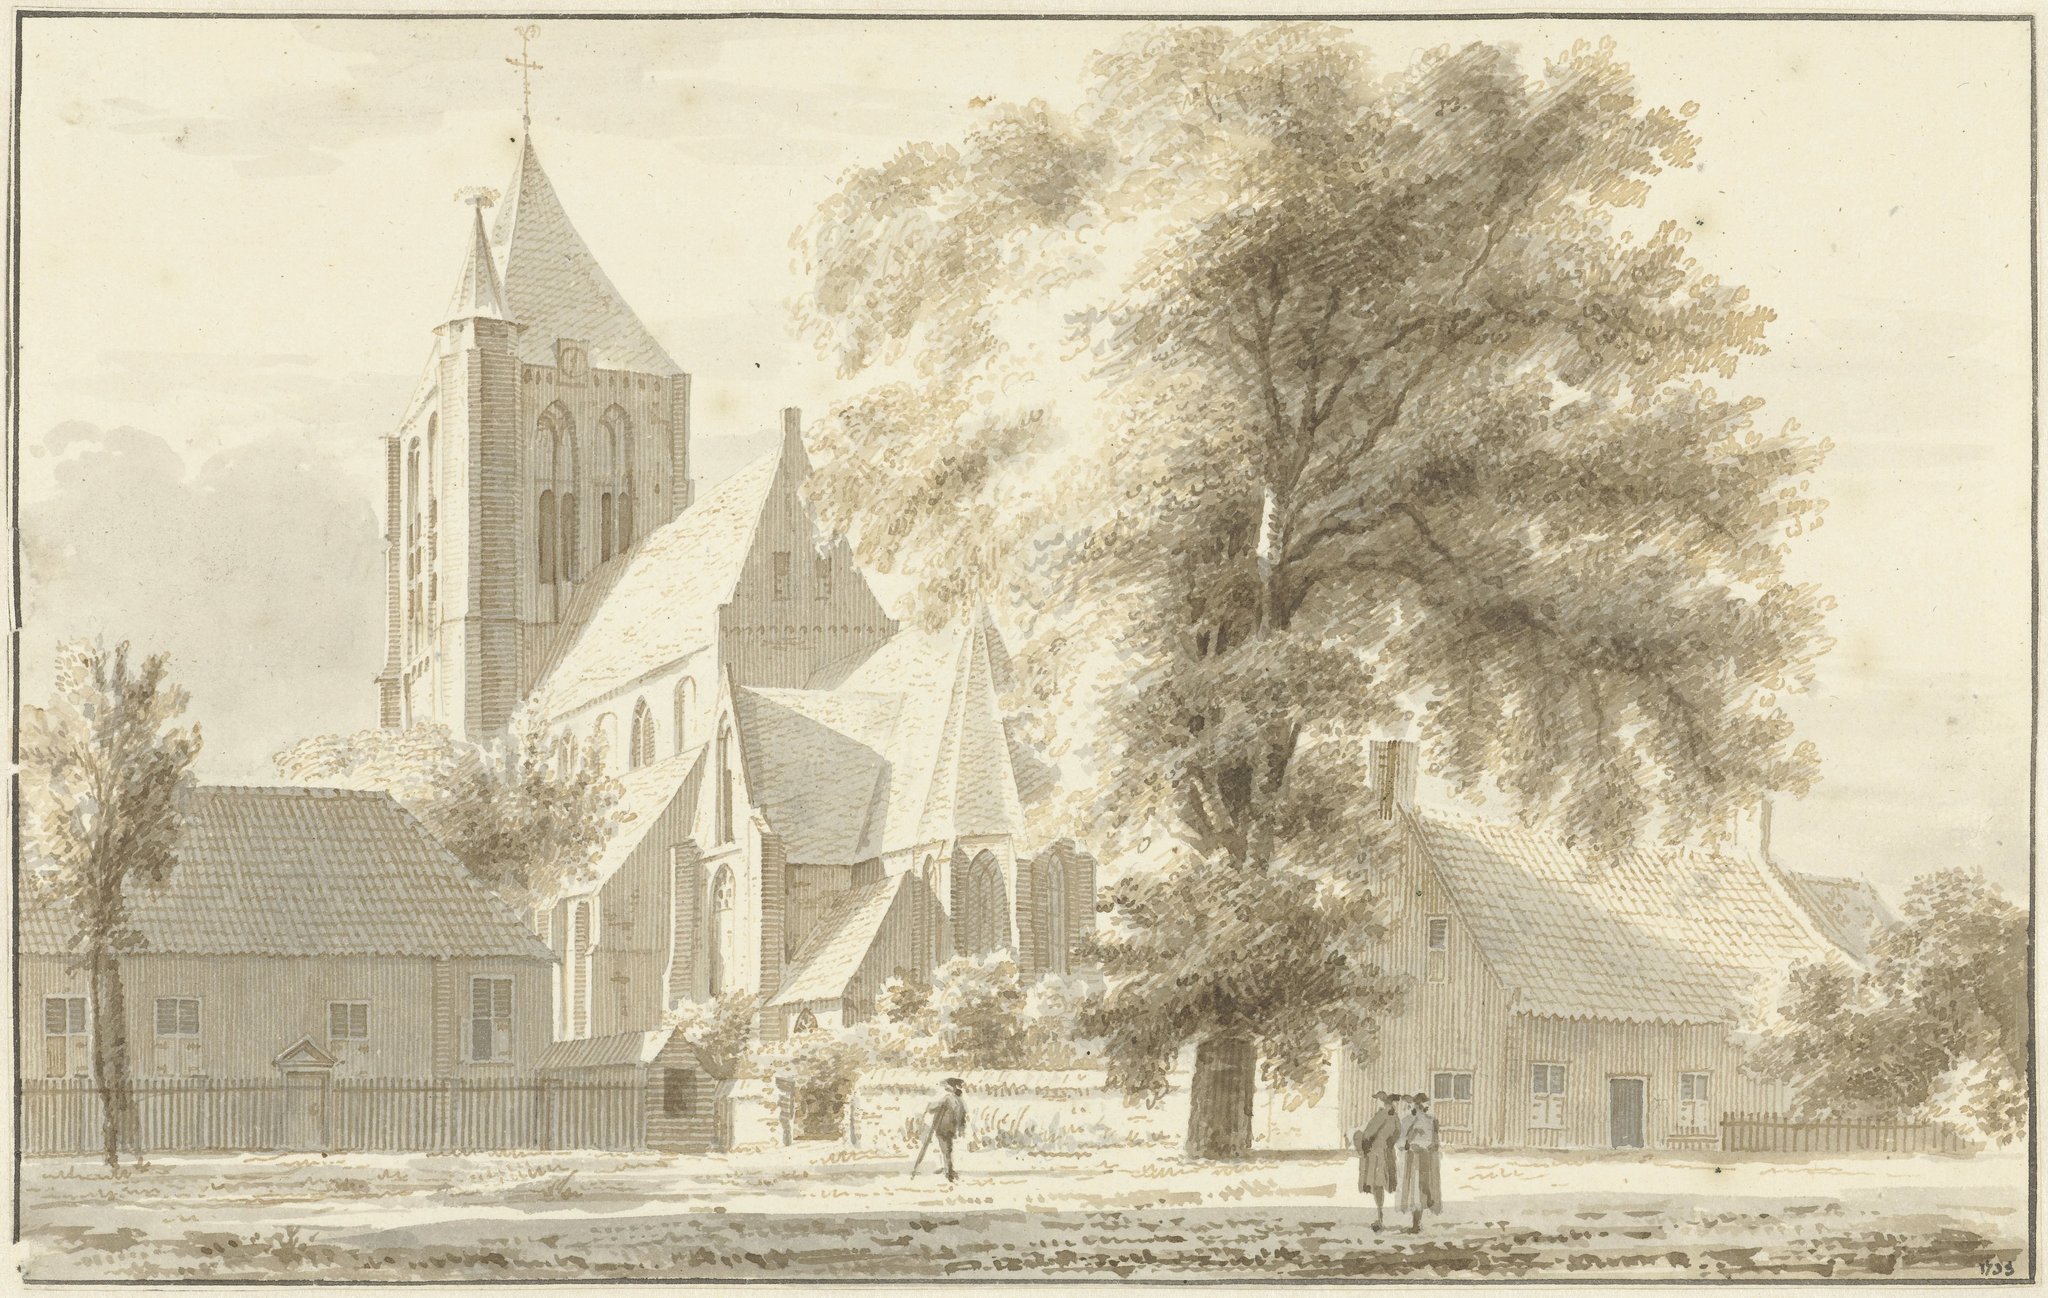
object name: drawing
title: De kerk van Geffen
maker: abraham de haen (ii)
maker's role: draughtsman, print maker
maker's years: 1707-1748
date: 1733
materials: ink, paper, pencil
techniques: brush, pen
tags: church (exterior)